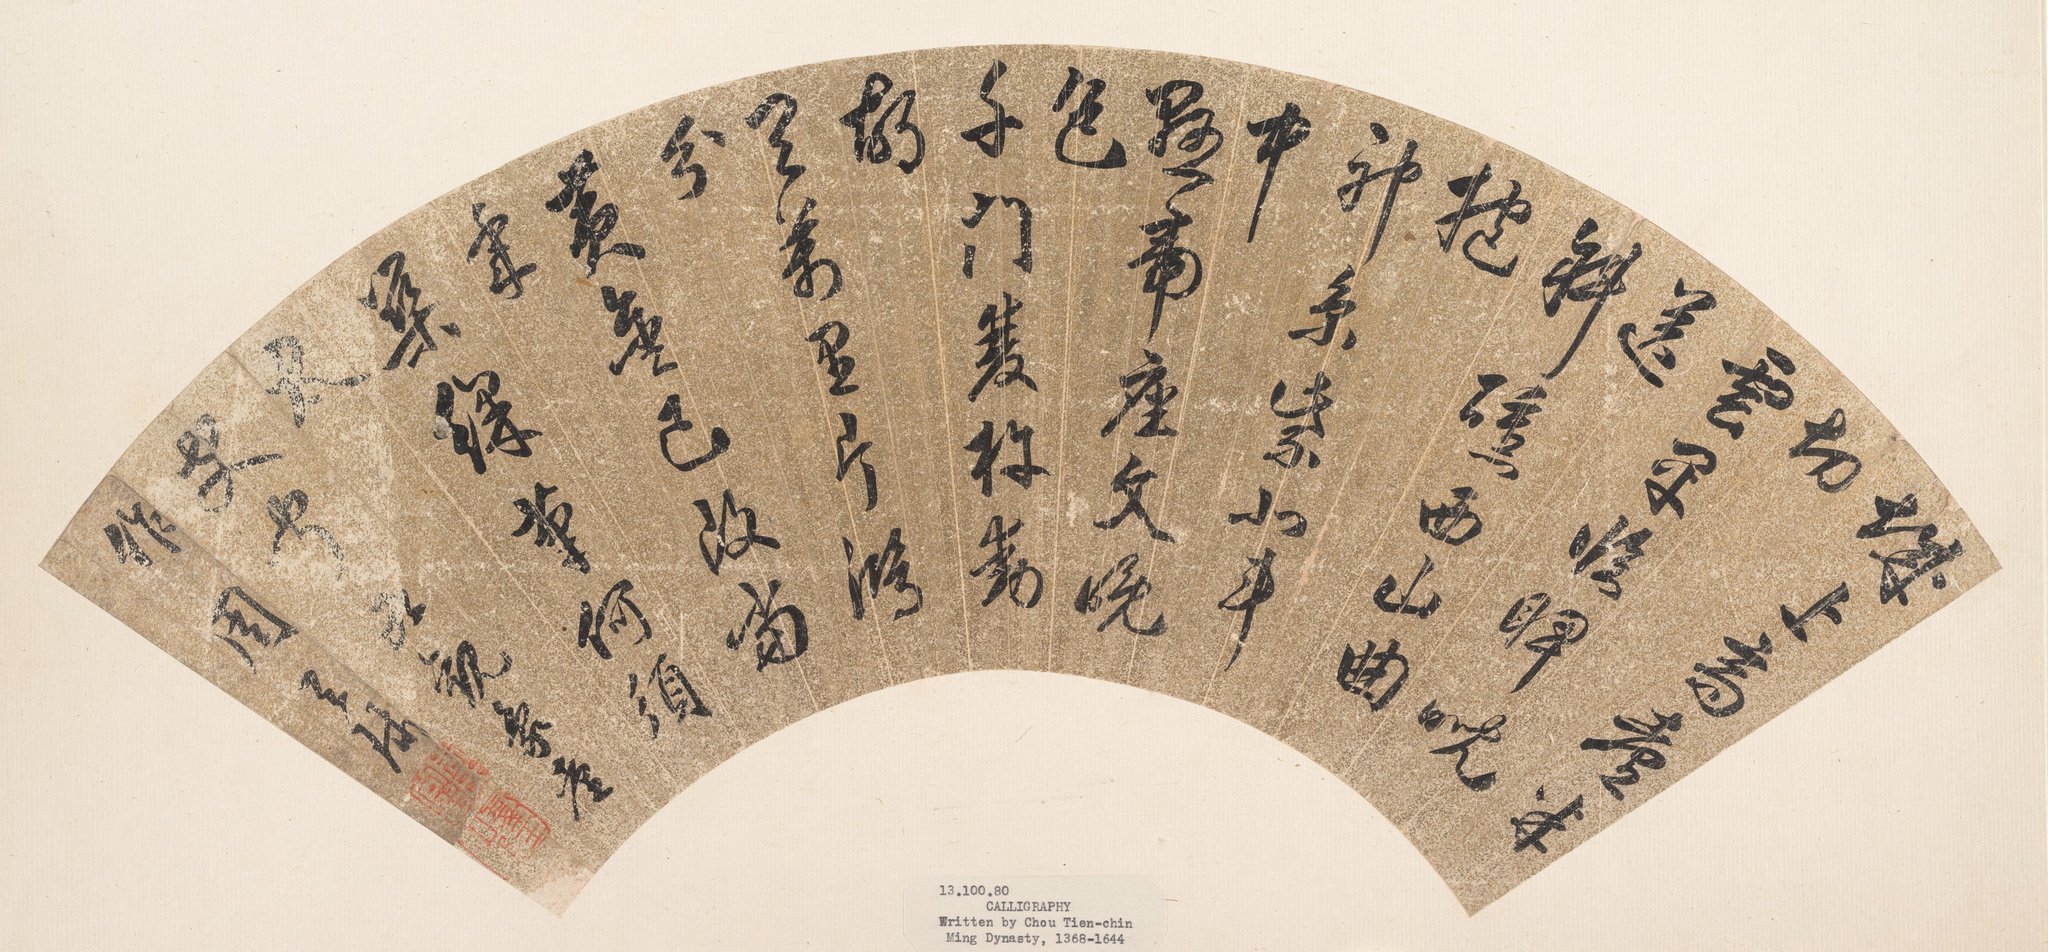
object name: folding fan mounted a an album leaf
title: Calligraphy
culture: chinese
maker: unidentified artist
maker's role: artist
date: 1368-1644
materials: gold, ink, paper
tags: calligraphy